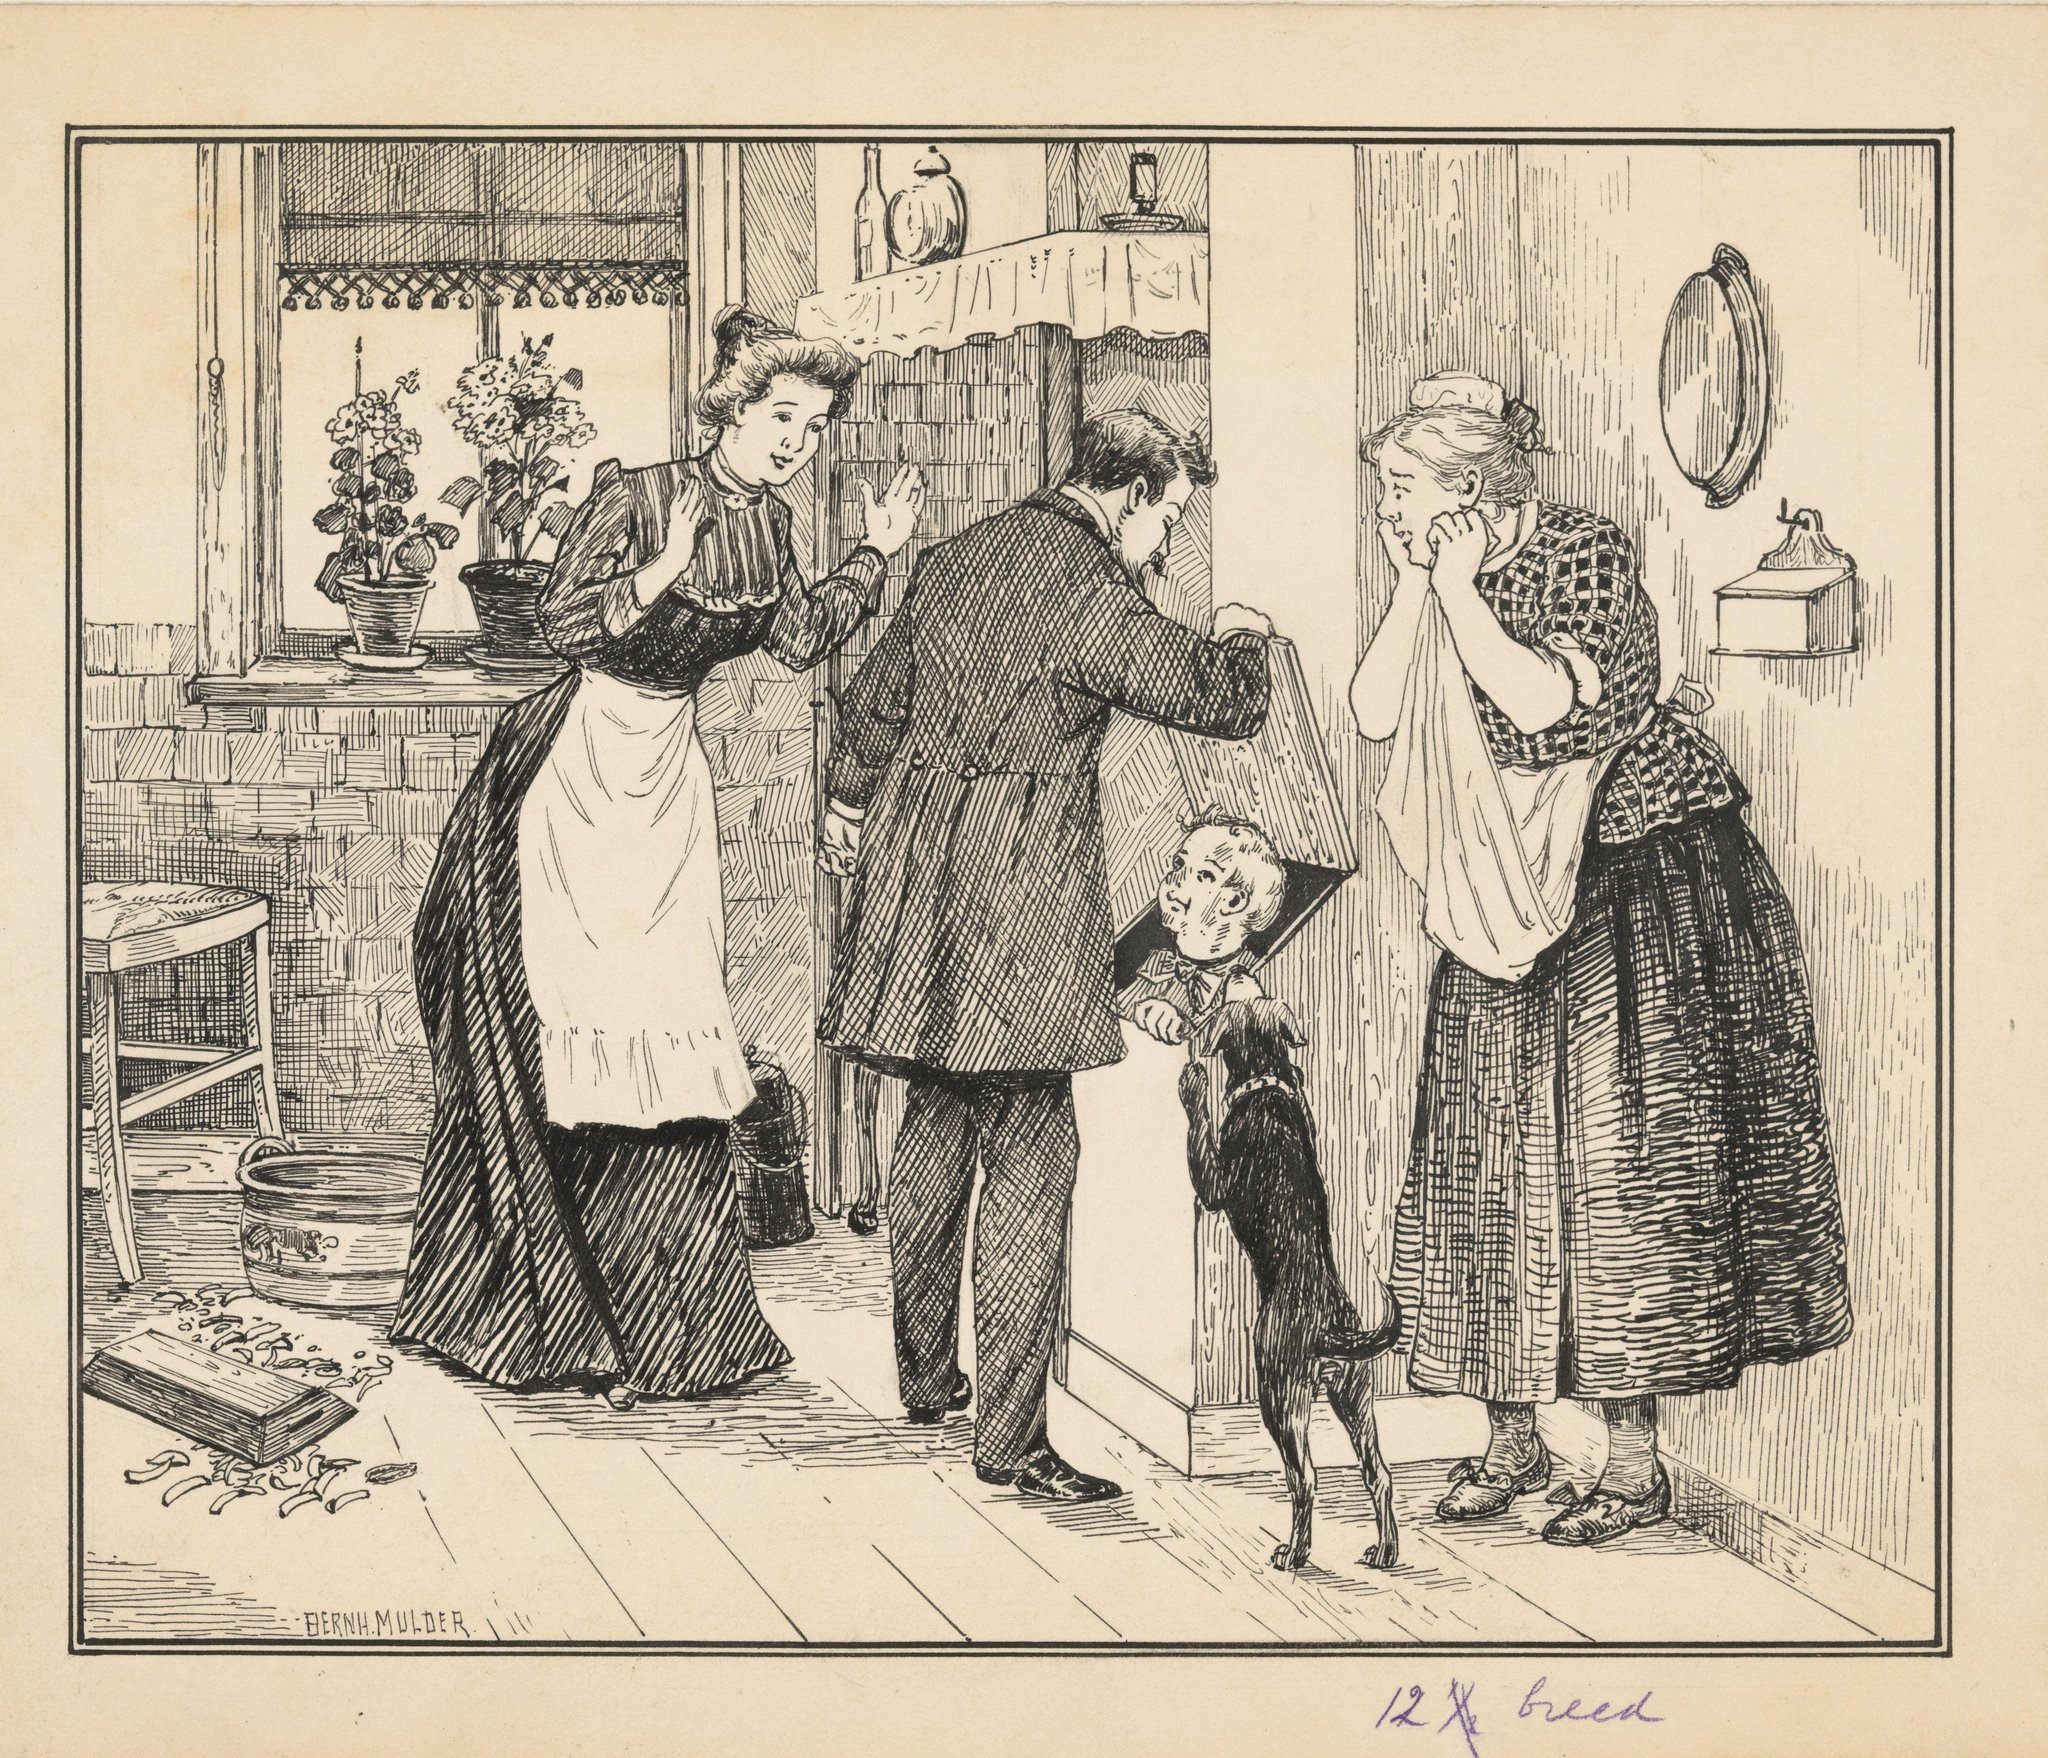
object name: drawing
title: Verstopte jongen wordt ontdekt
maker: gillis bernhard mulder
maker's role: draughtsman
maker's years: 1875-1938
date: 1885-1938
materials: ink, paper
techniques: pen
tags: boy (child between toddler and youth), open hearth, fire-place, hiding, hiding oneself, dog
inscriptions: signature: ‘BERNH. MULDER.’, collector's mark: Lugt 2228, number:, :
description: Een man, twee geschrokken vrouwen en een hond staan in een interieur naast een haard. De man tilt een luik op in de muur naast de haard. Uit het gat steekt het hoofd van een jongen met een beroet gezicht.